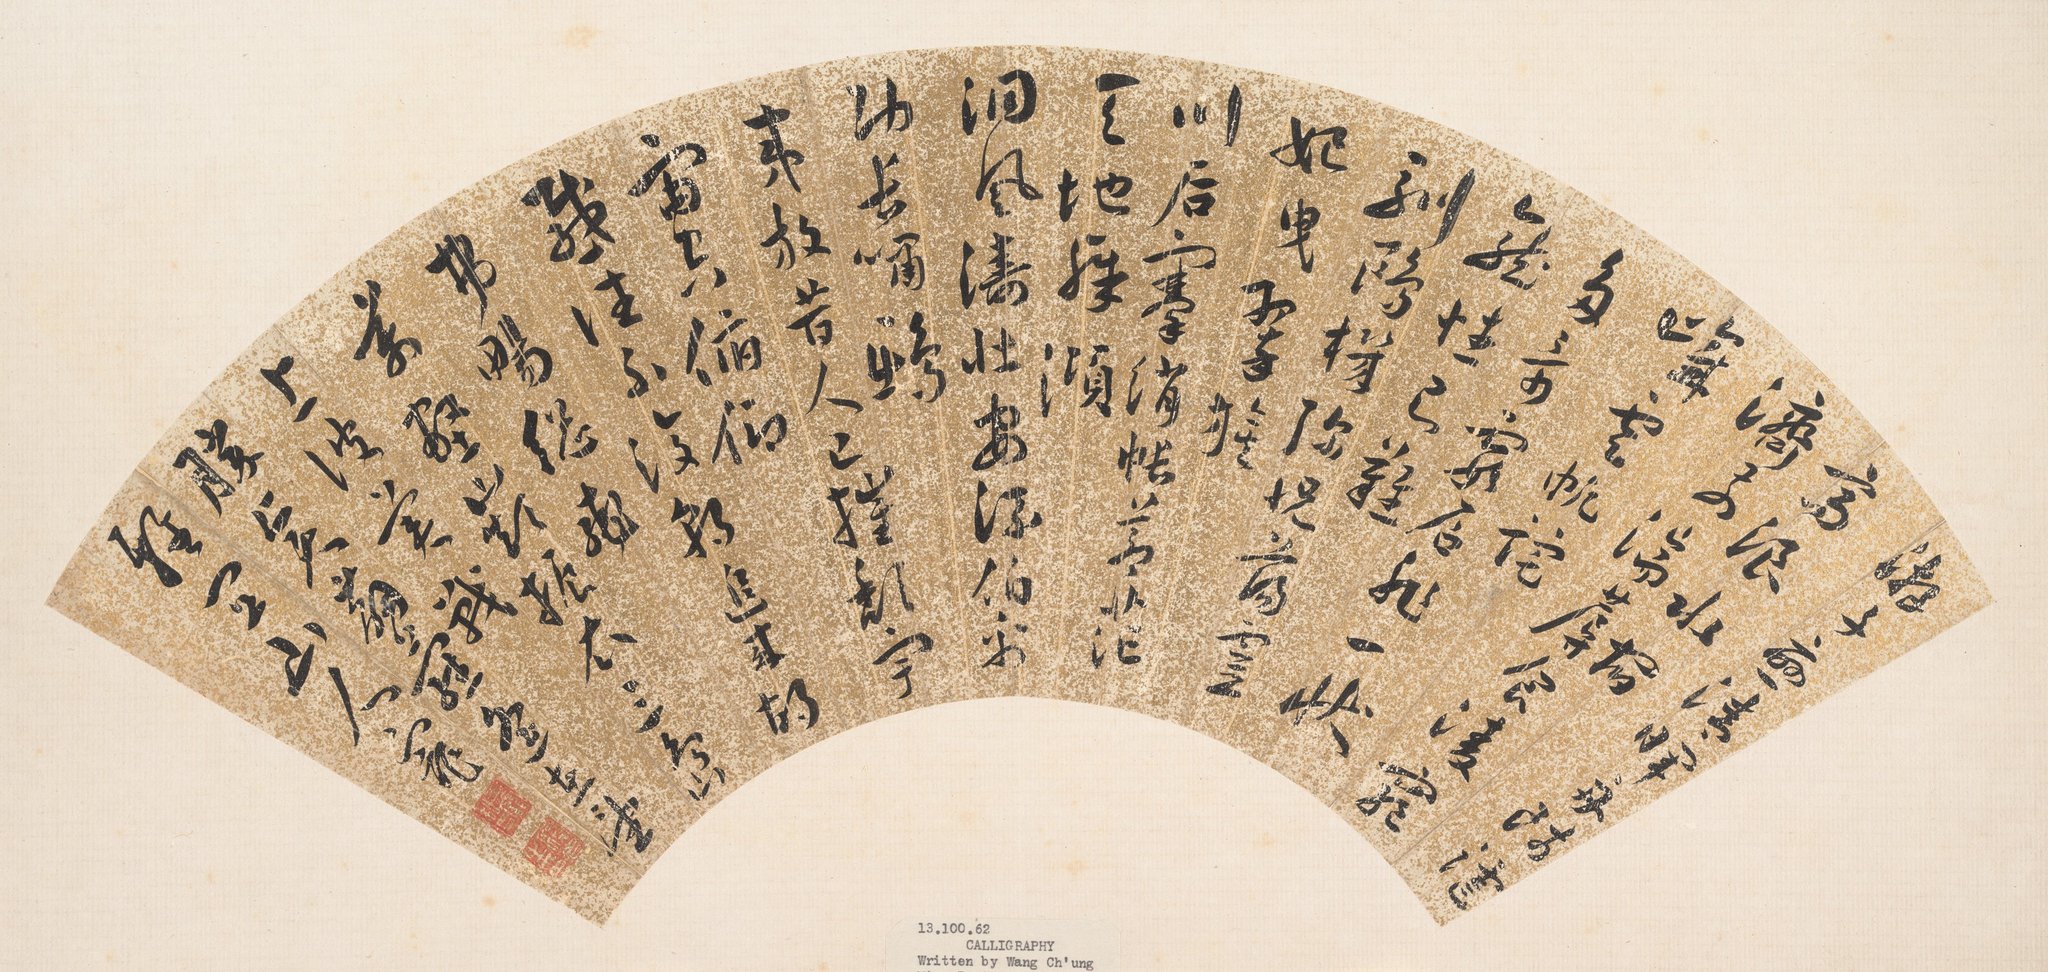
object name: folding fan mounted a an album leaf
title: Calligraphy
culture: chinese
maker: unidentified artist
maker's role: artist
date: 1501-1600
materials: ink, paper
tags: calligraphy